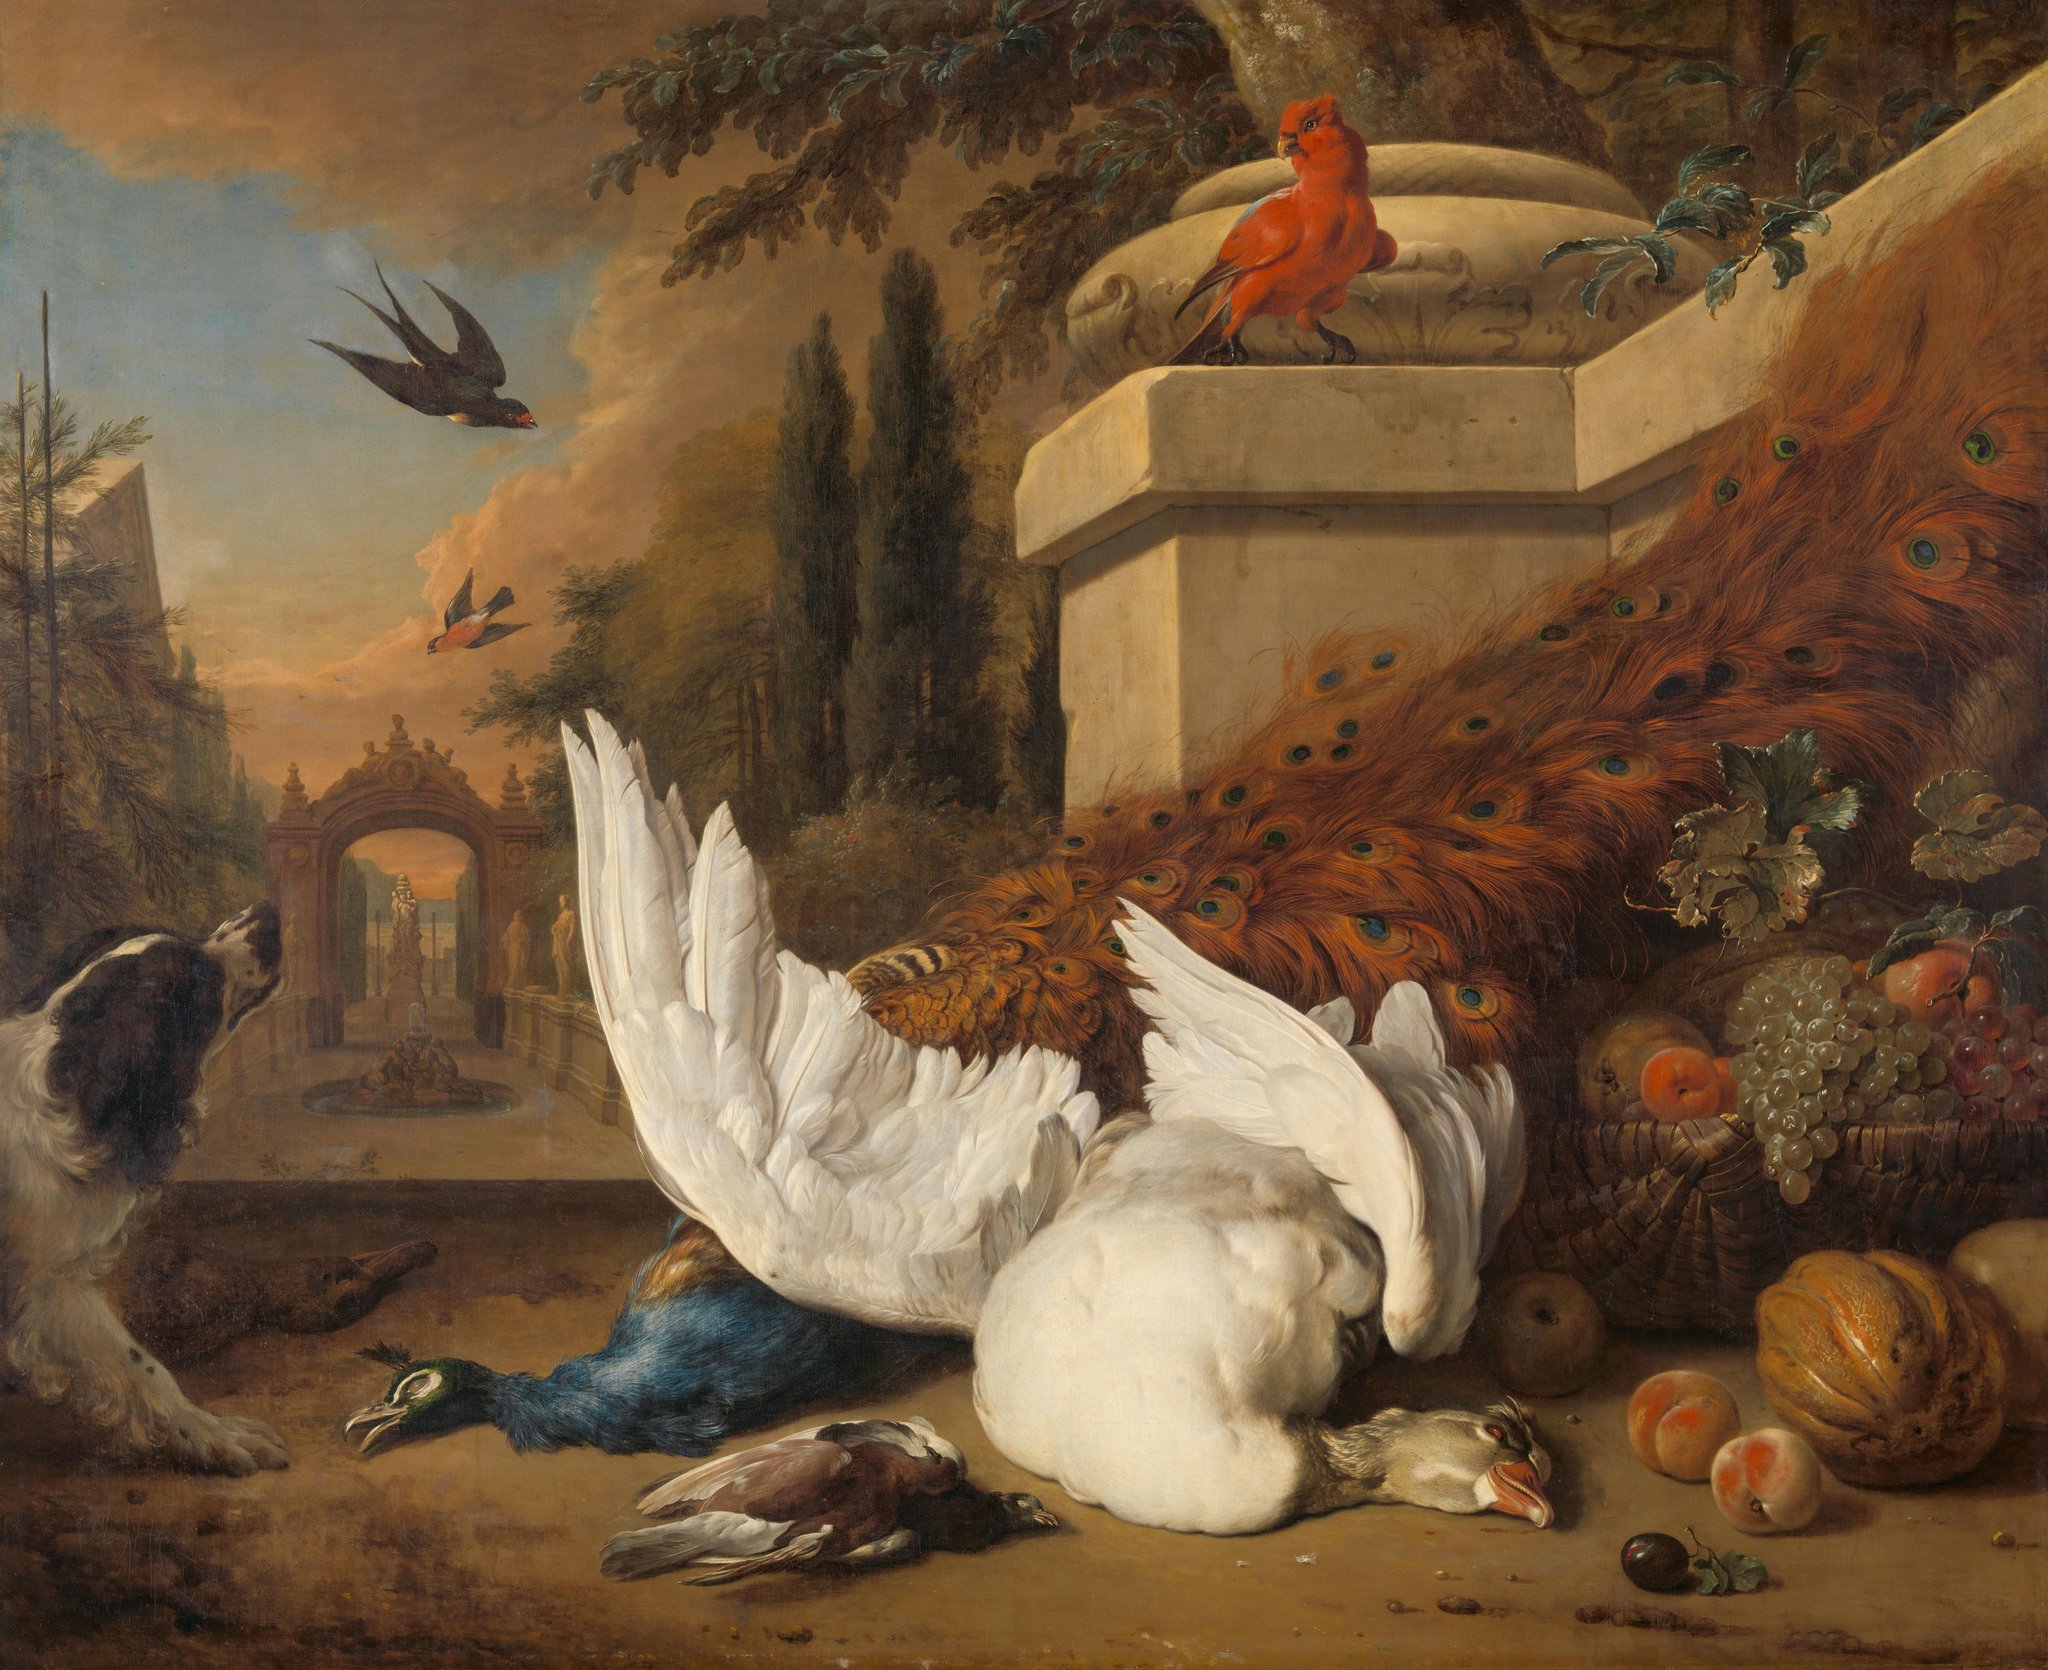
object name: painting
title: A Dog with a dead Goose and Peacock (A Study of Game and Fruit)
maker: jan weenix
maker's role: draughtsman, painter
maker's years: 1640-1719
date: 1700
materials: canvas, oil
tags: hunting dogs, spoils of the hunt, game, venison, dog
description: Een hond bij een stilleven van gevogelte (dode gans en een pauw) en fruit (druiven, meloen, perziken en appels). Op een balustrade zit een papegaai, in de lucht enkele andere vogels. Op de achtergrond een laan in een park of tuin.